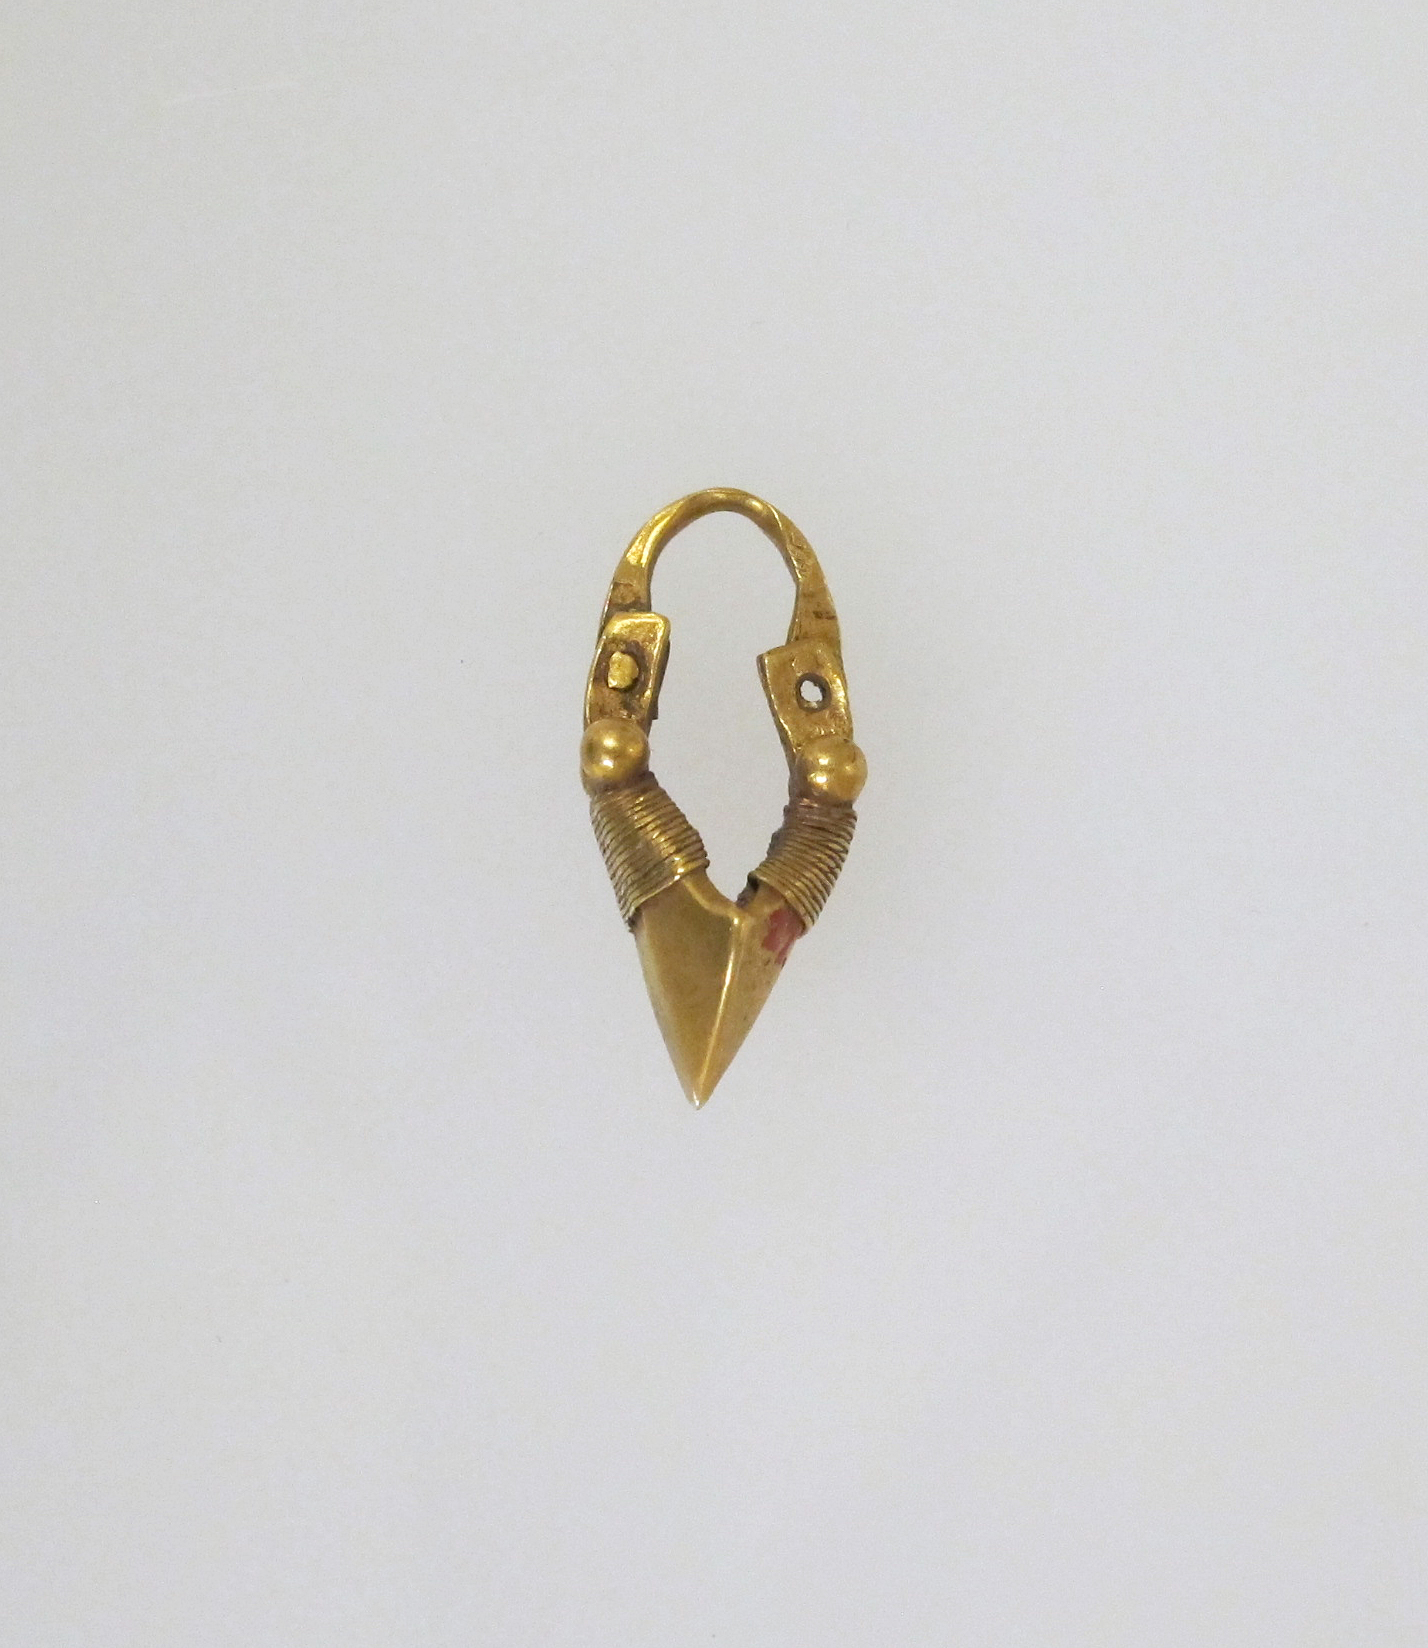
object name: earring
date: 7000 BCE-330 CE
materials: gold